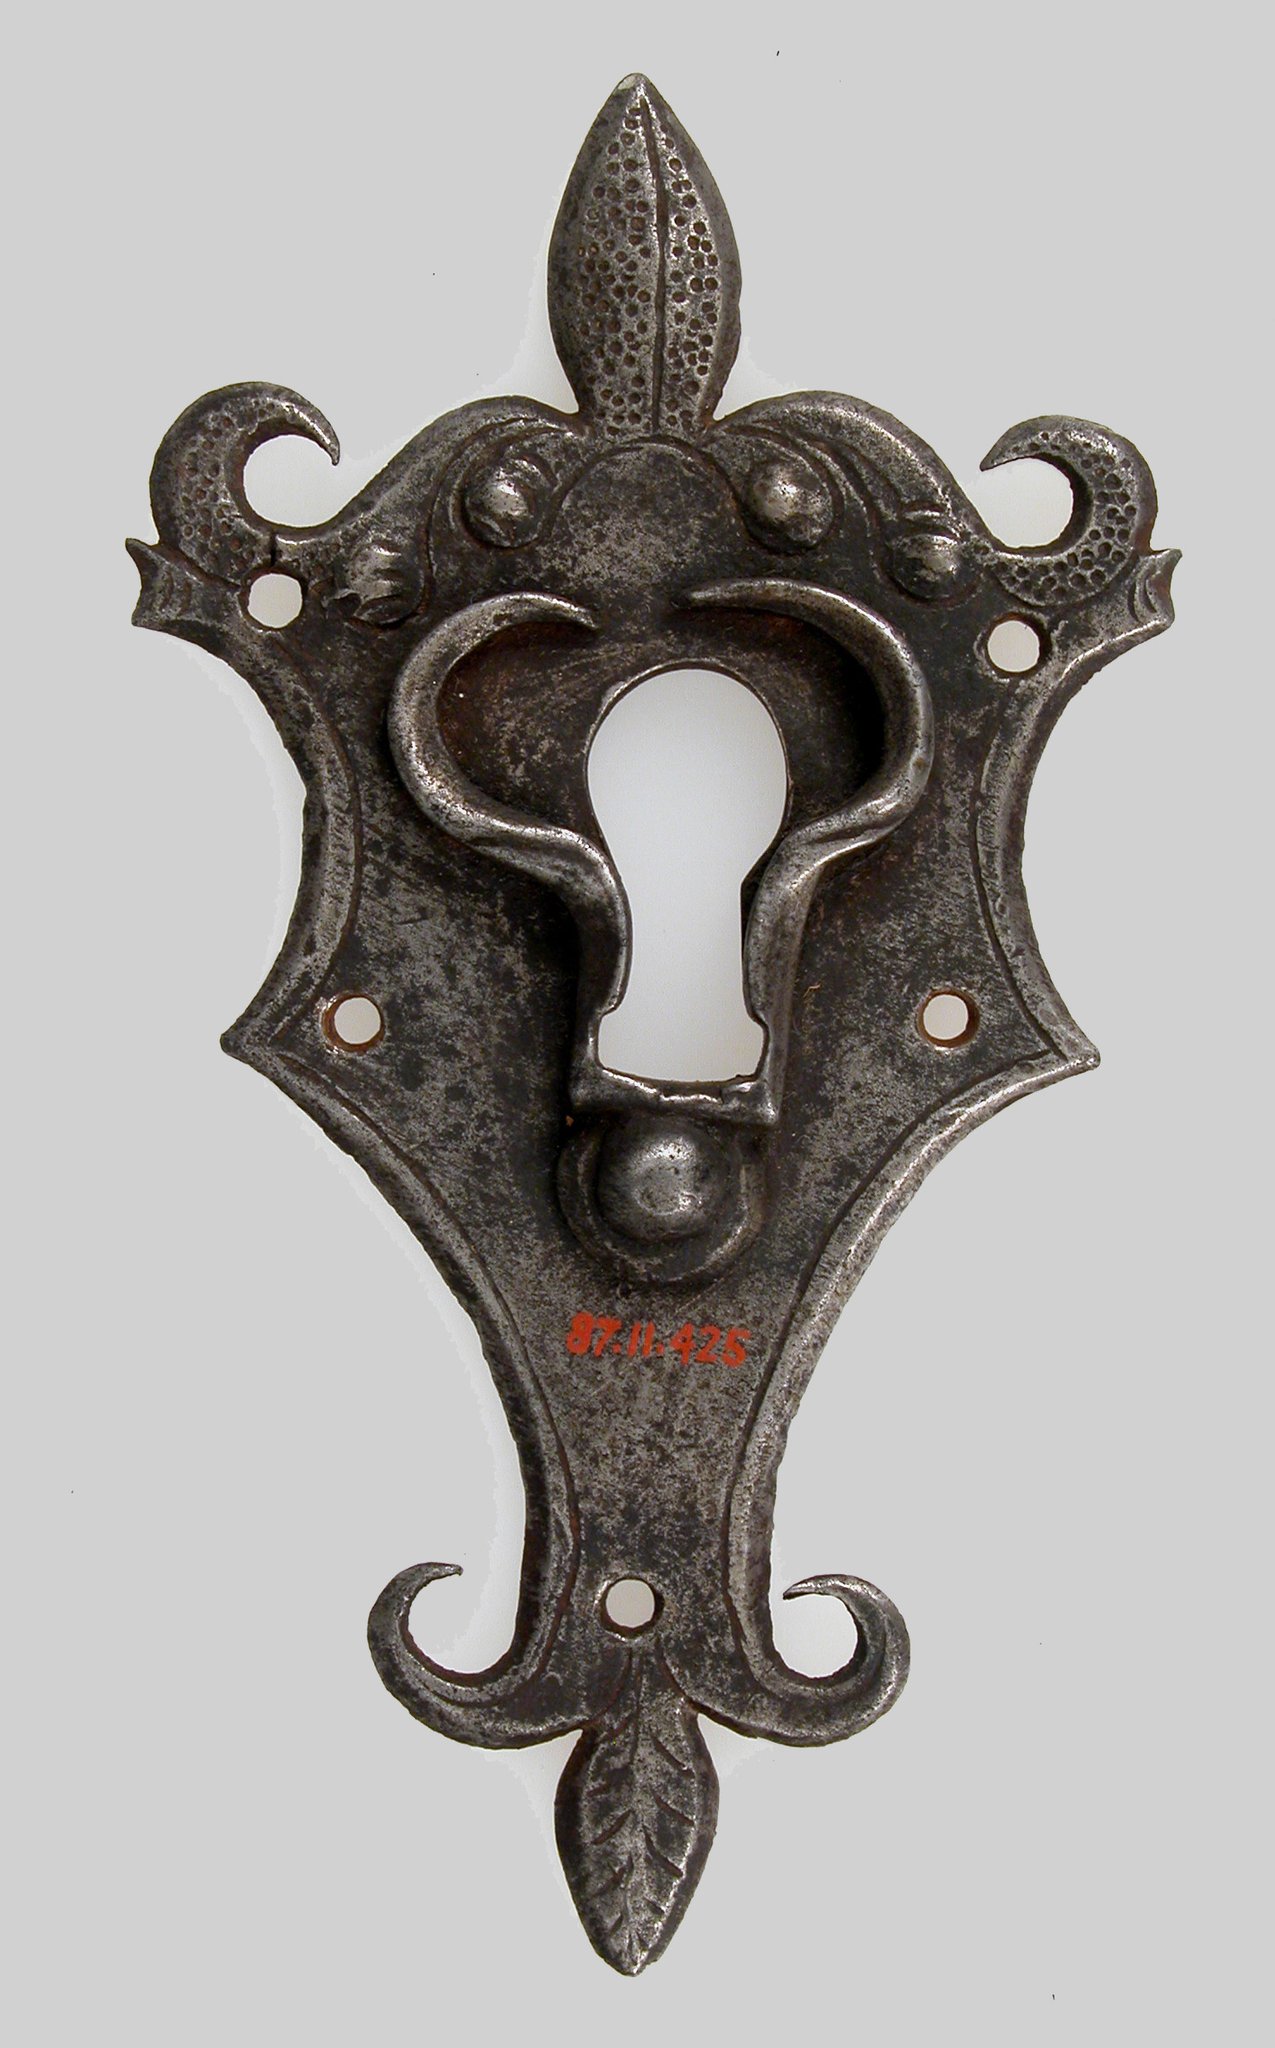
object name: escutcheon plate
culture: german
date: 1501-1600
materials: iron